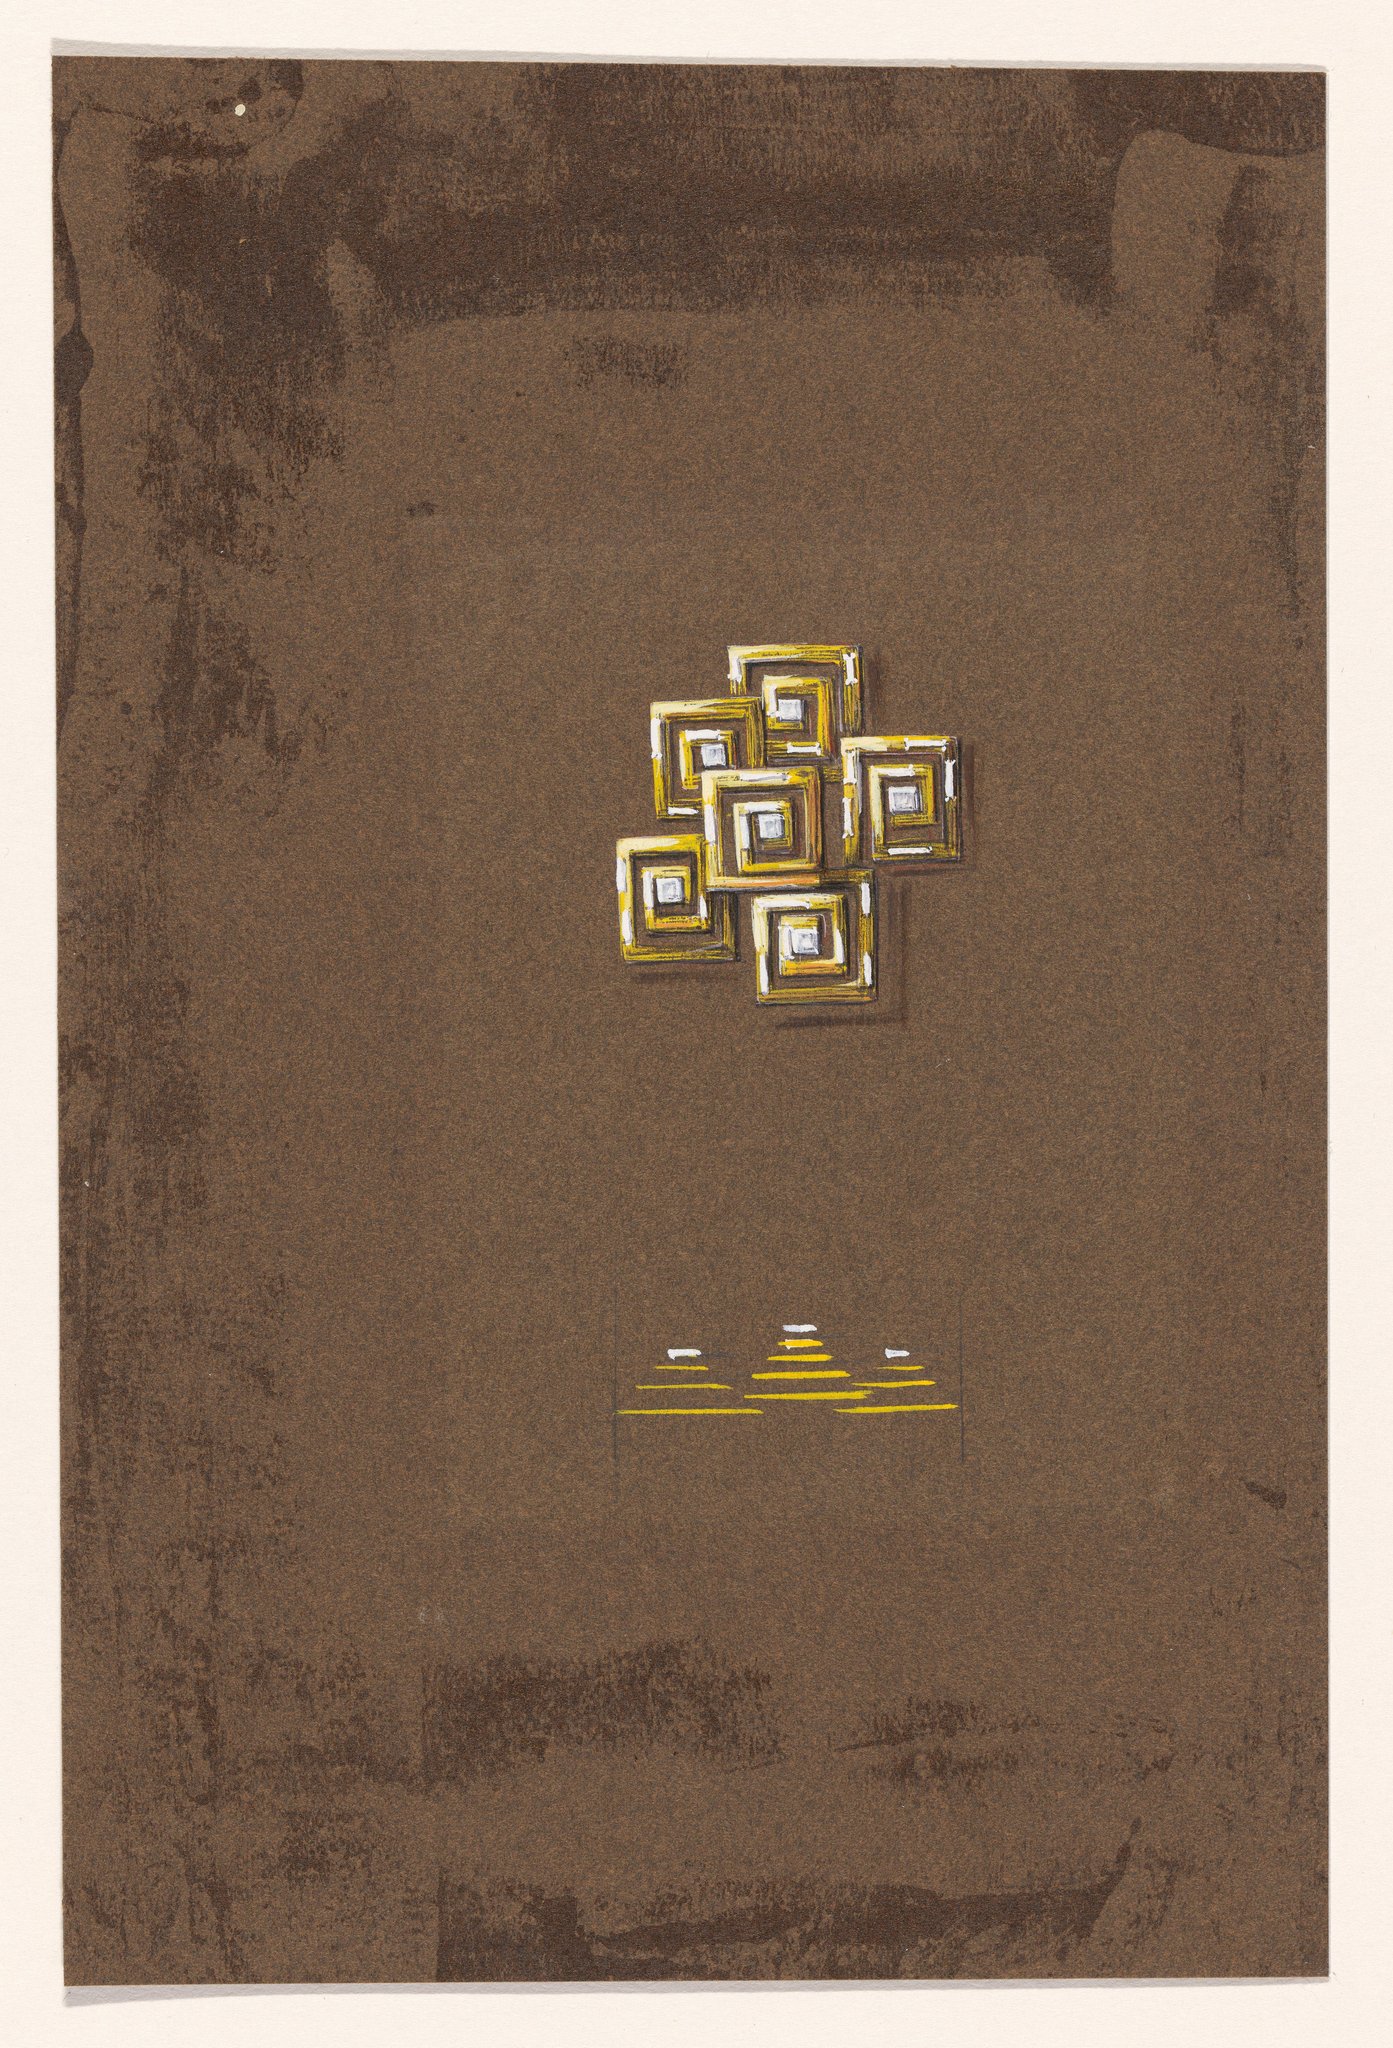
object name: design drawing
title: Broche van goud met diamanten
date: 1960-1980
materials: paint, paper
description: In veilingcatalogus op naam gesteld van Andrew Grima.